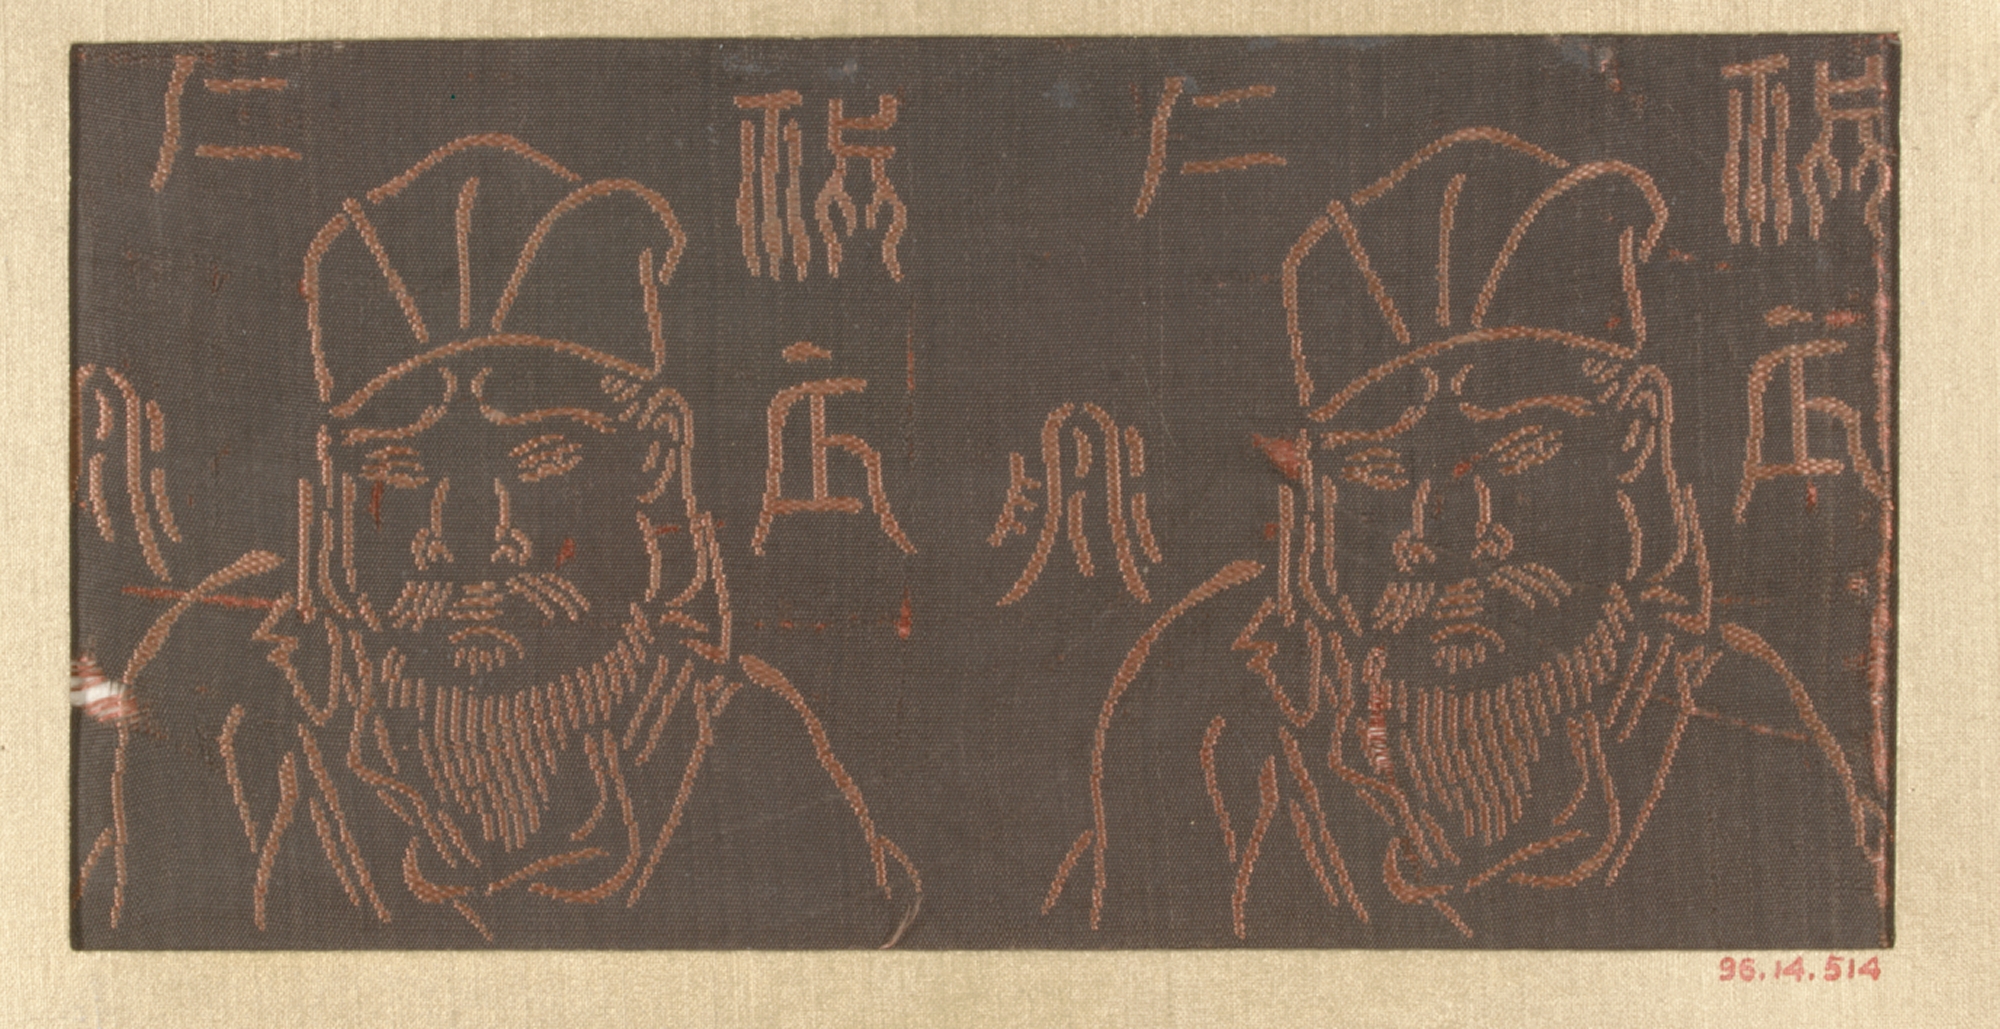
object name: piece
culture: japanese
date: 1701-1900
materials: silk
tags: human figures